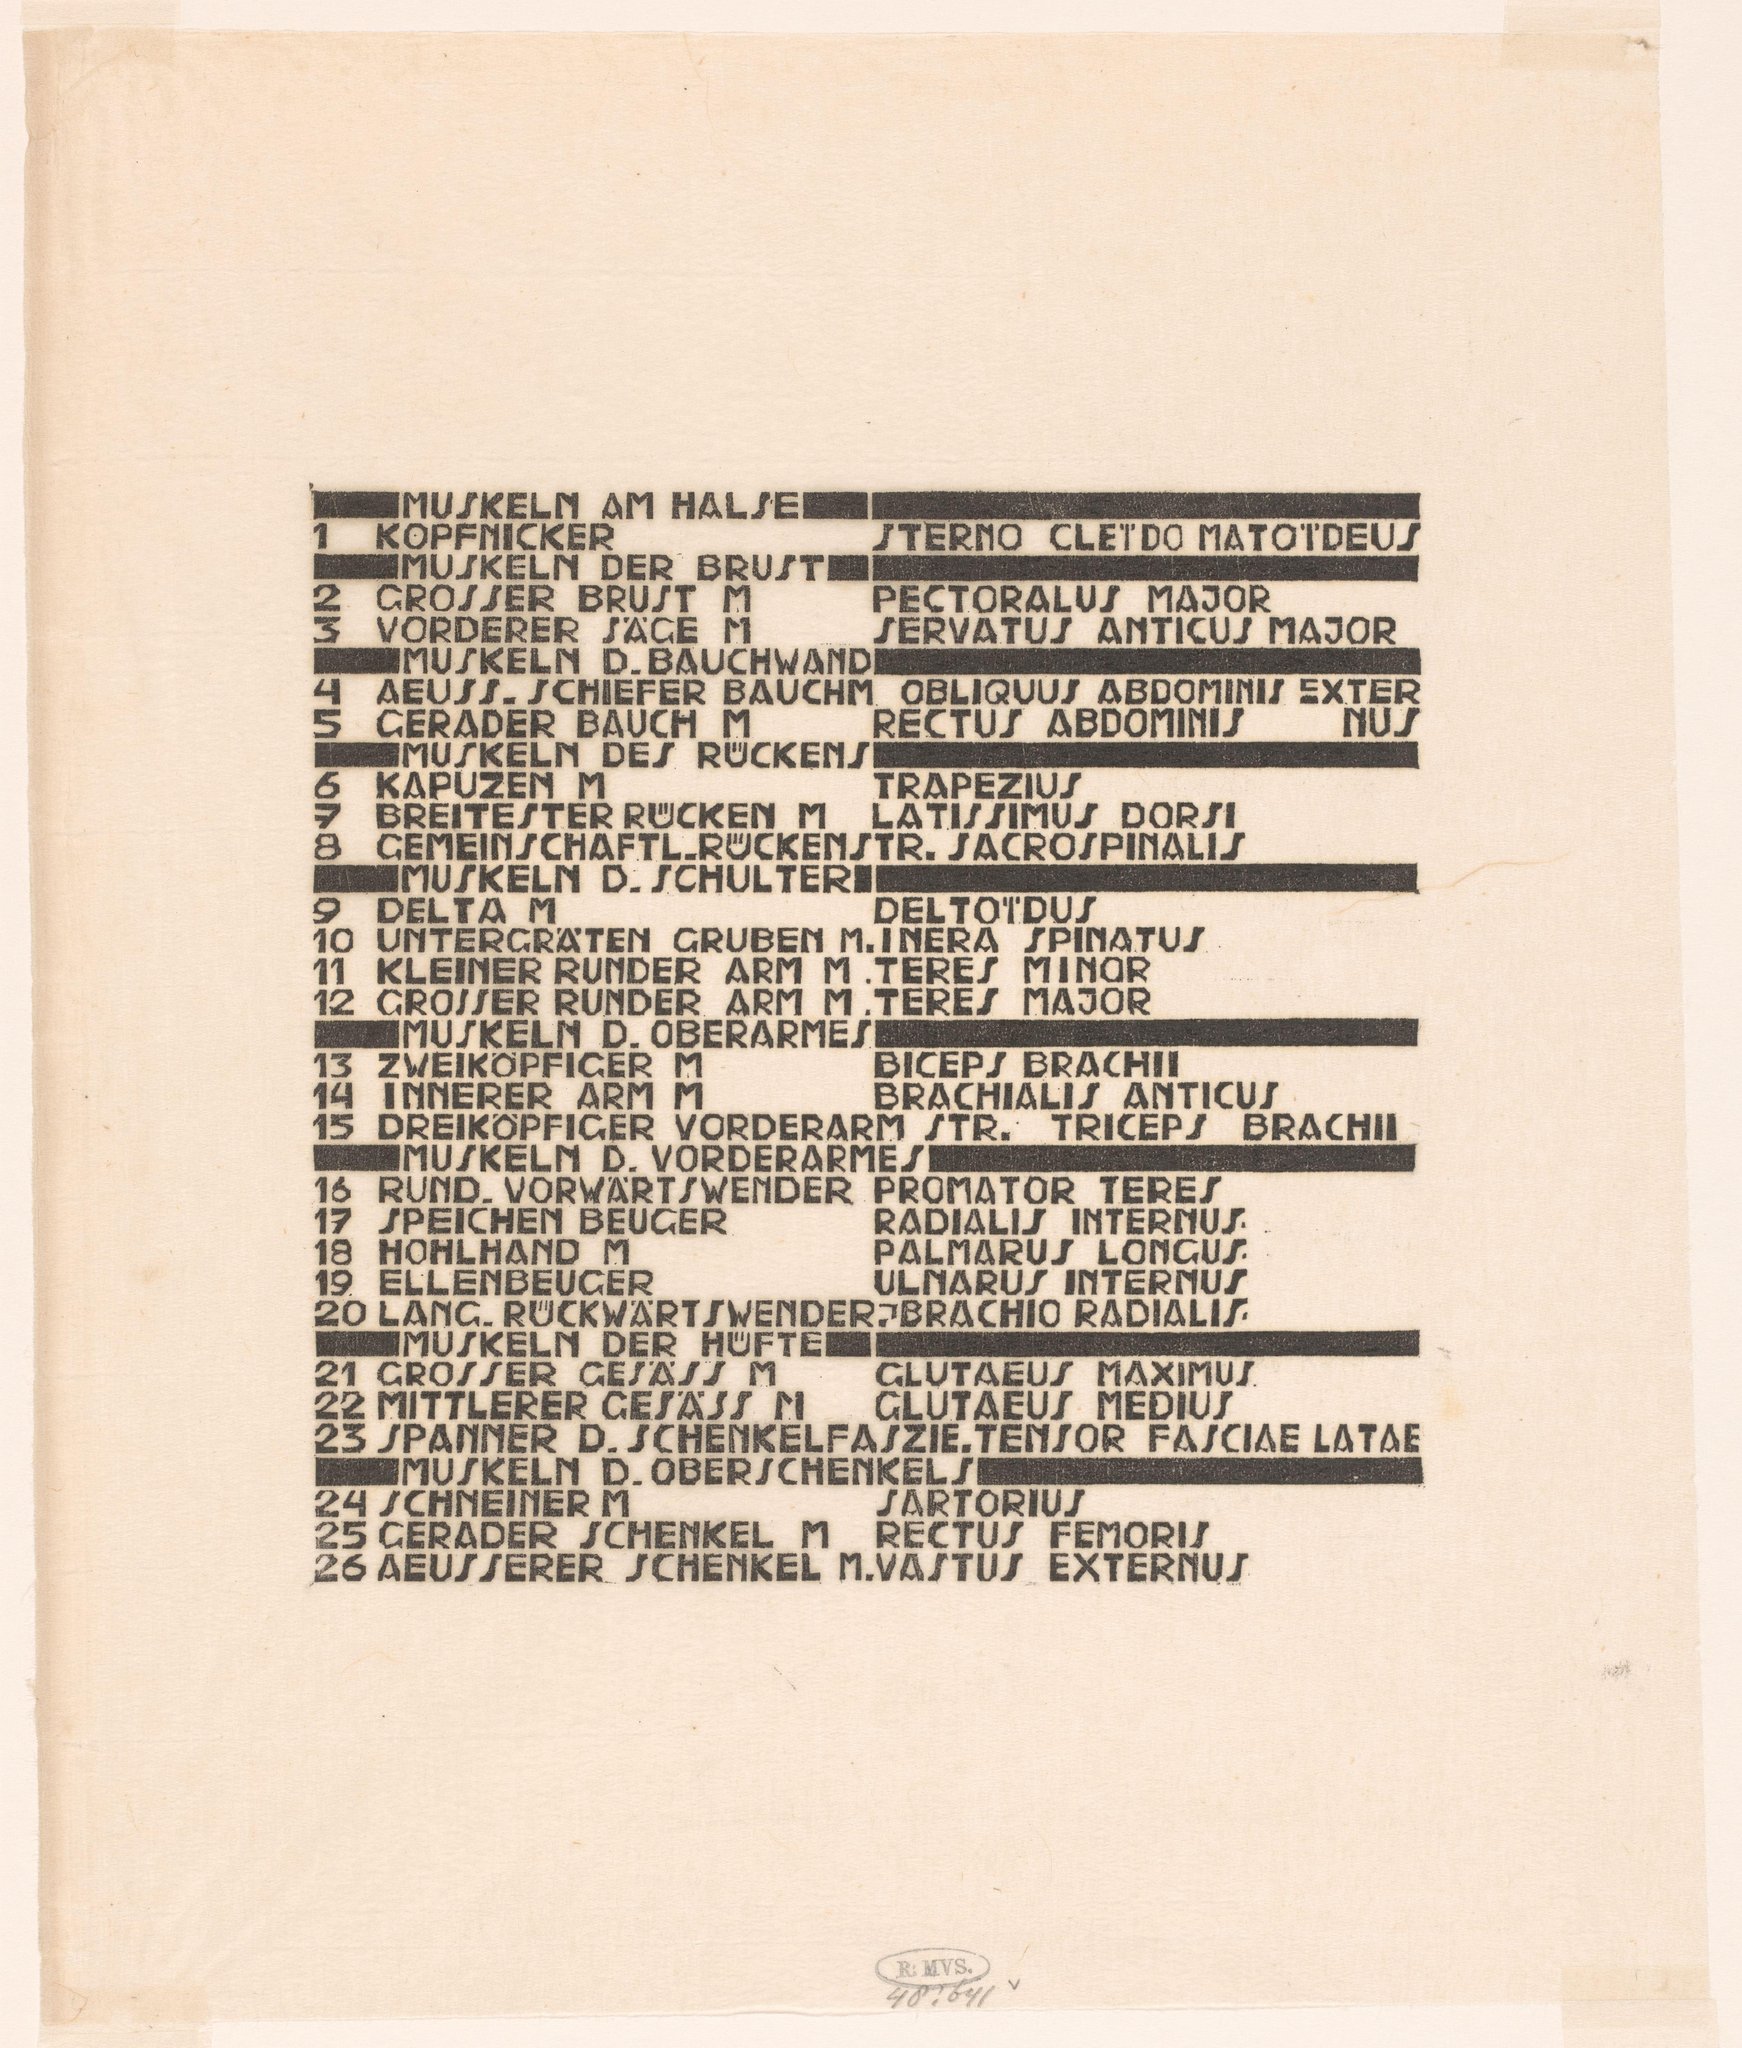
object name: print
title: Lijst van rug- en armspieren in Duits en Latijn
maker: reijer stolk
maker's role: draughtsman, print maker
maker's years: 1896-1945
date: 1906-1945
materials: paper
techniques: woodcut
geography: netherlands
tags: muscles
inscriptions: collector's mark: Lugt 2228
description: Prent gebruikt voor: Stolk, Reyer. Anatomische studies in houtsneden. Amsterdam: G.W. Breughel, 1946, plaat 2.